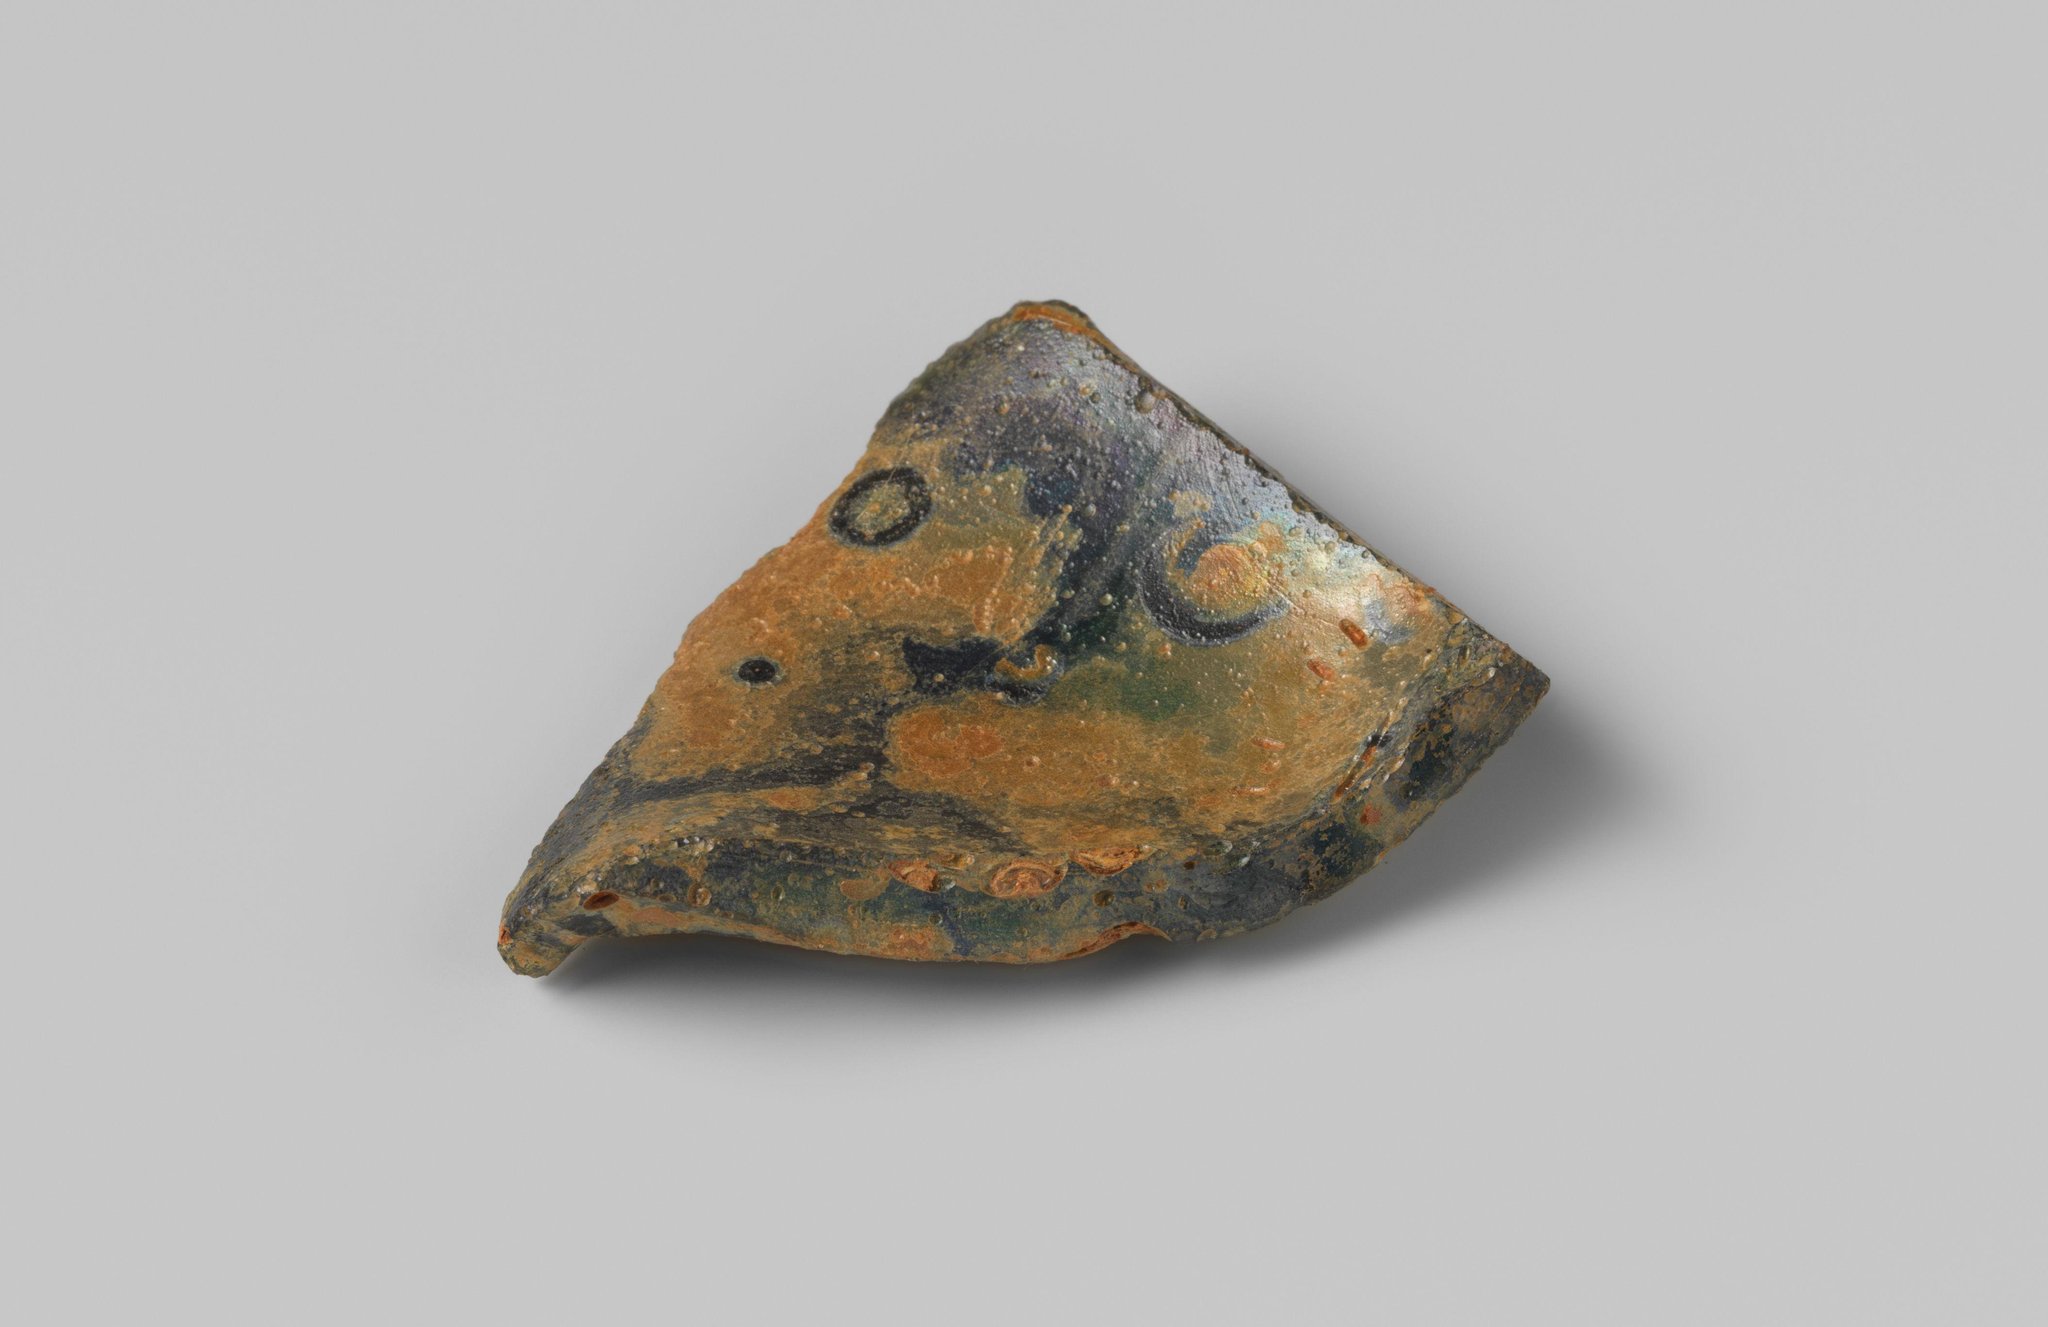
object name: wine bottle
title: Scherf van een wijnfles uit het wrak van de Oostindiëvaarder Hollandia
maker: Anonymous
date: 1700-1743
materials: glass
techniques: green glass